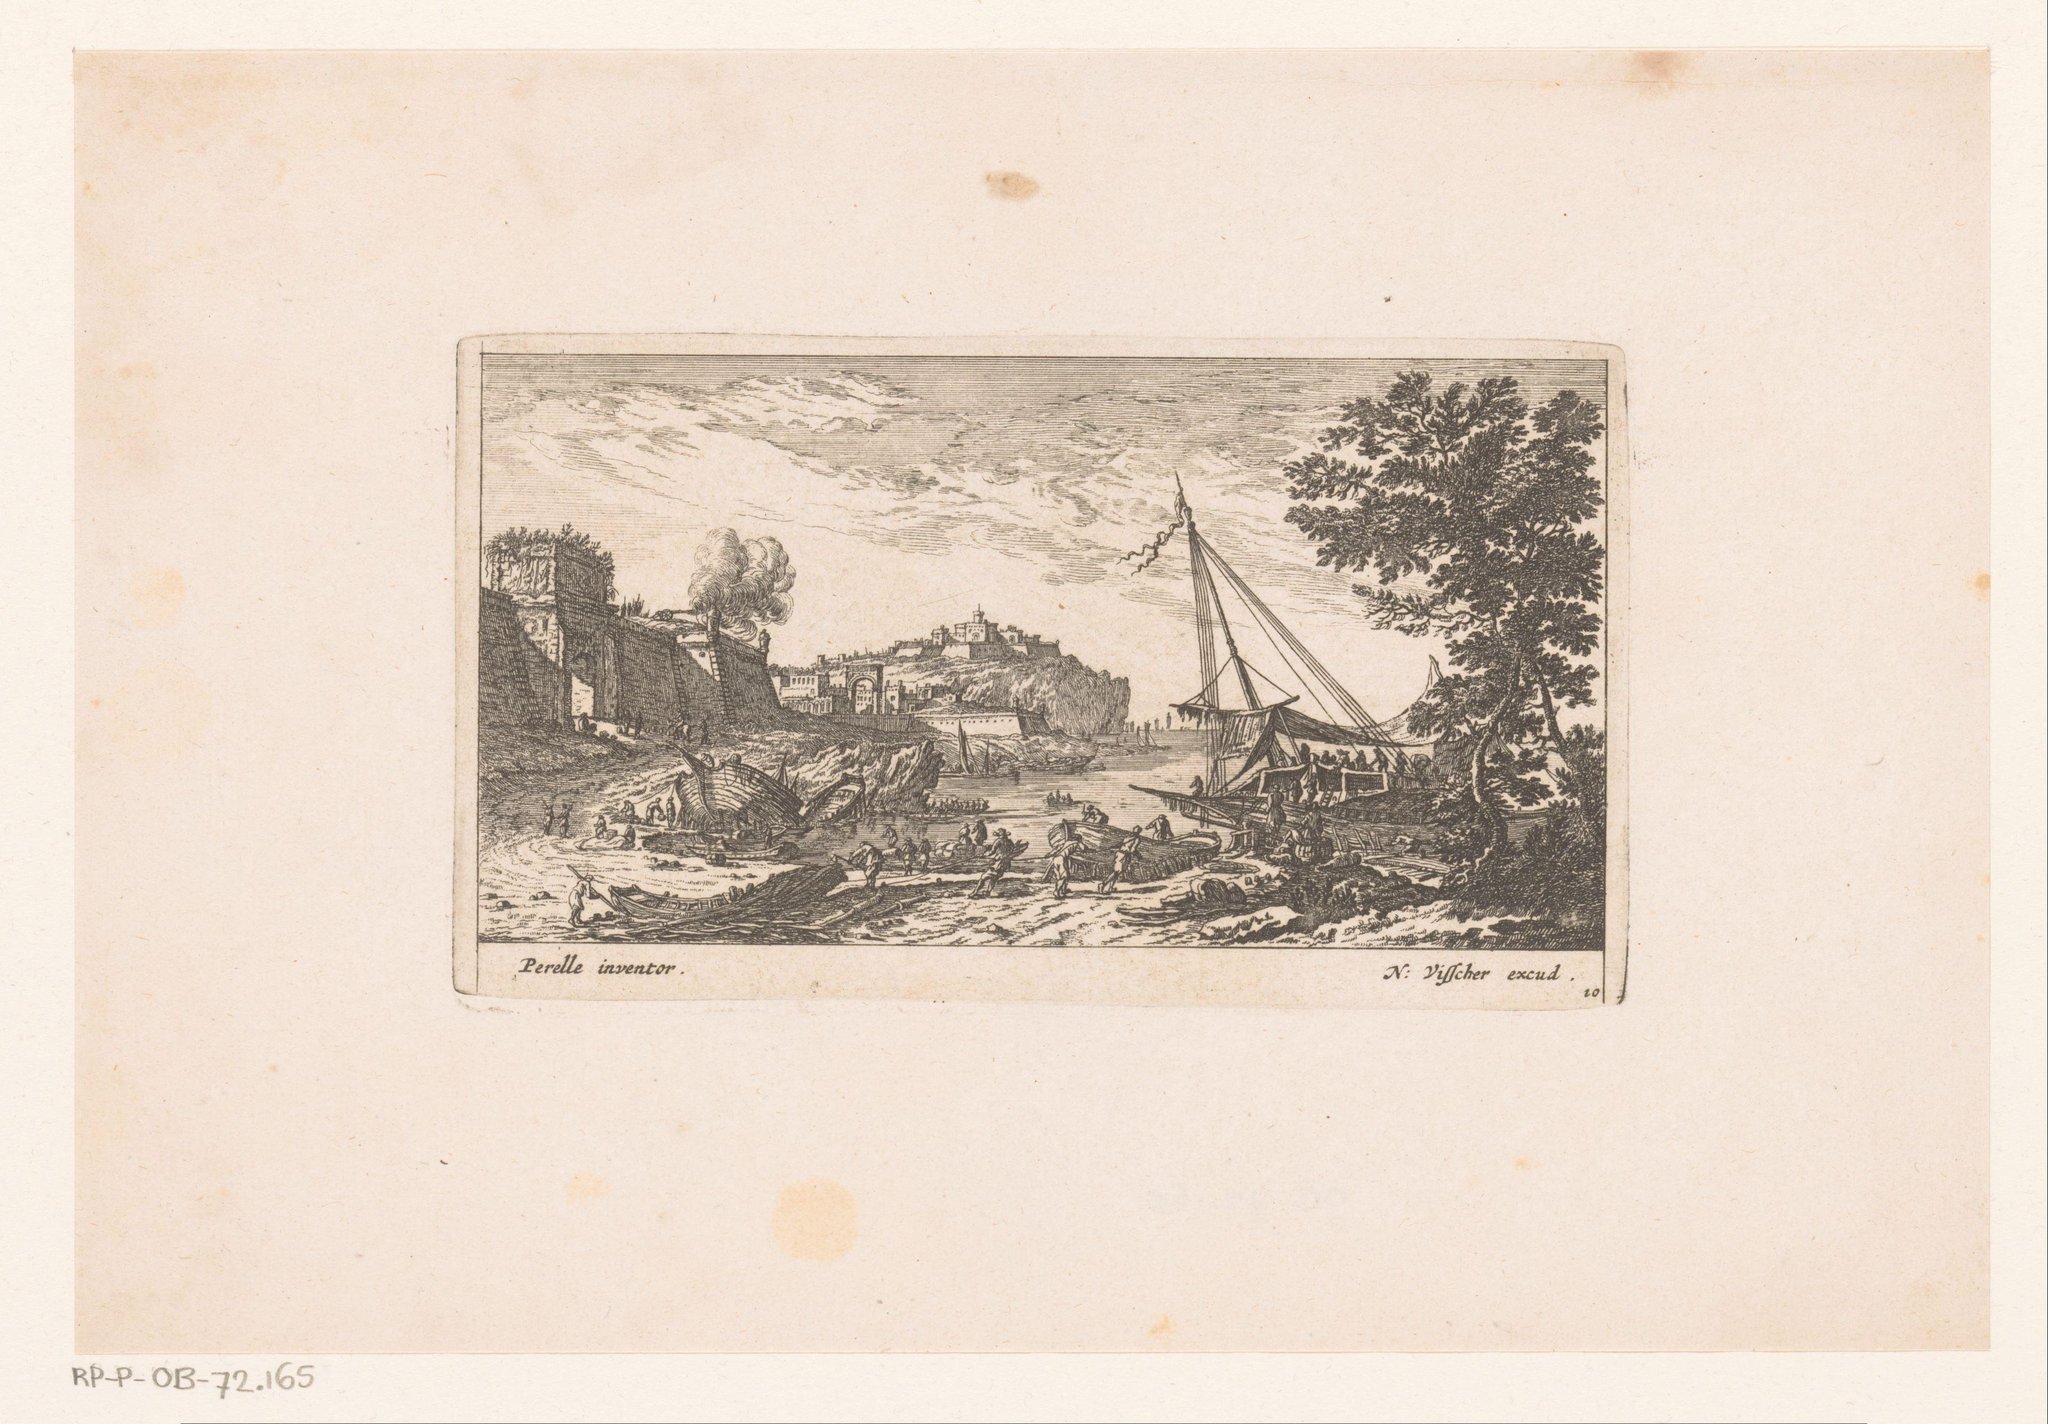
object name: print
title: Havengezicht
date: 1628-1679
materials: paper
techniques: etching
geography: amsterdam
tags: harbour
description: Prenten met het signatuur 'Perelle' kunnen zowel door vader Gabriel als door zonen Nicolas en Adam gemaakt zijn.